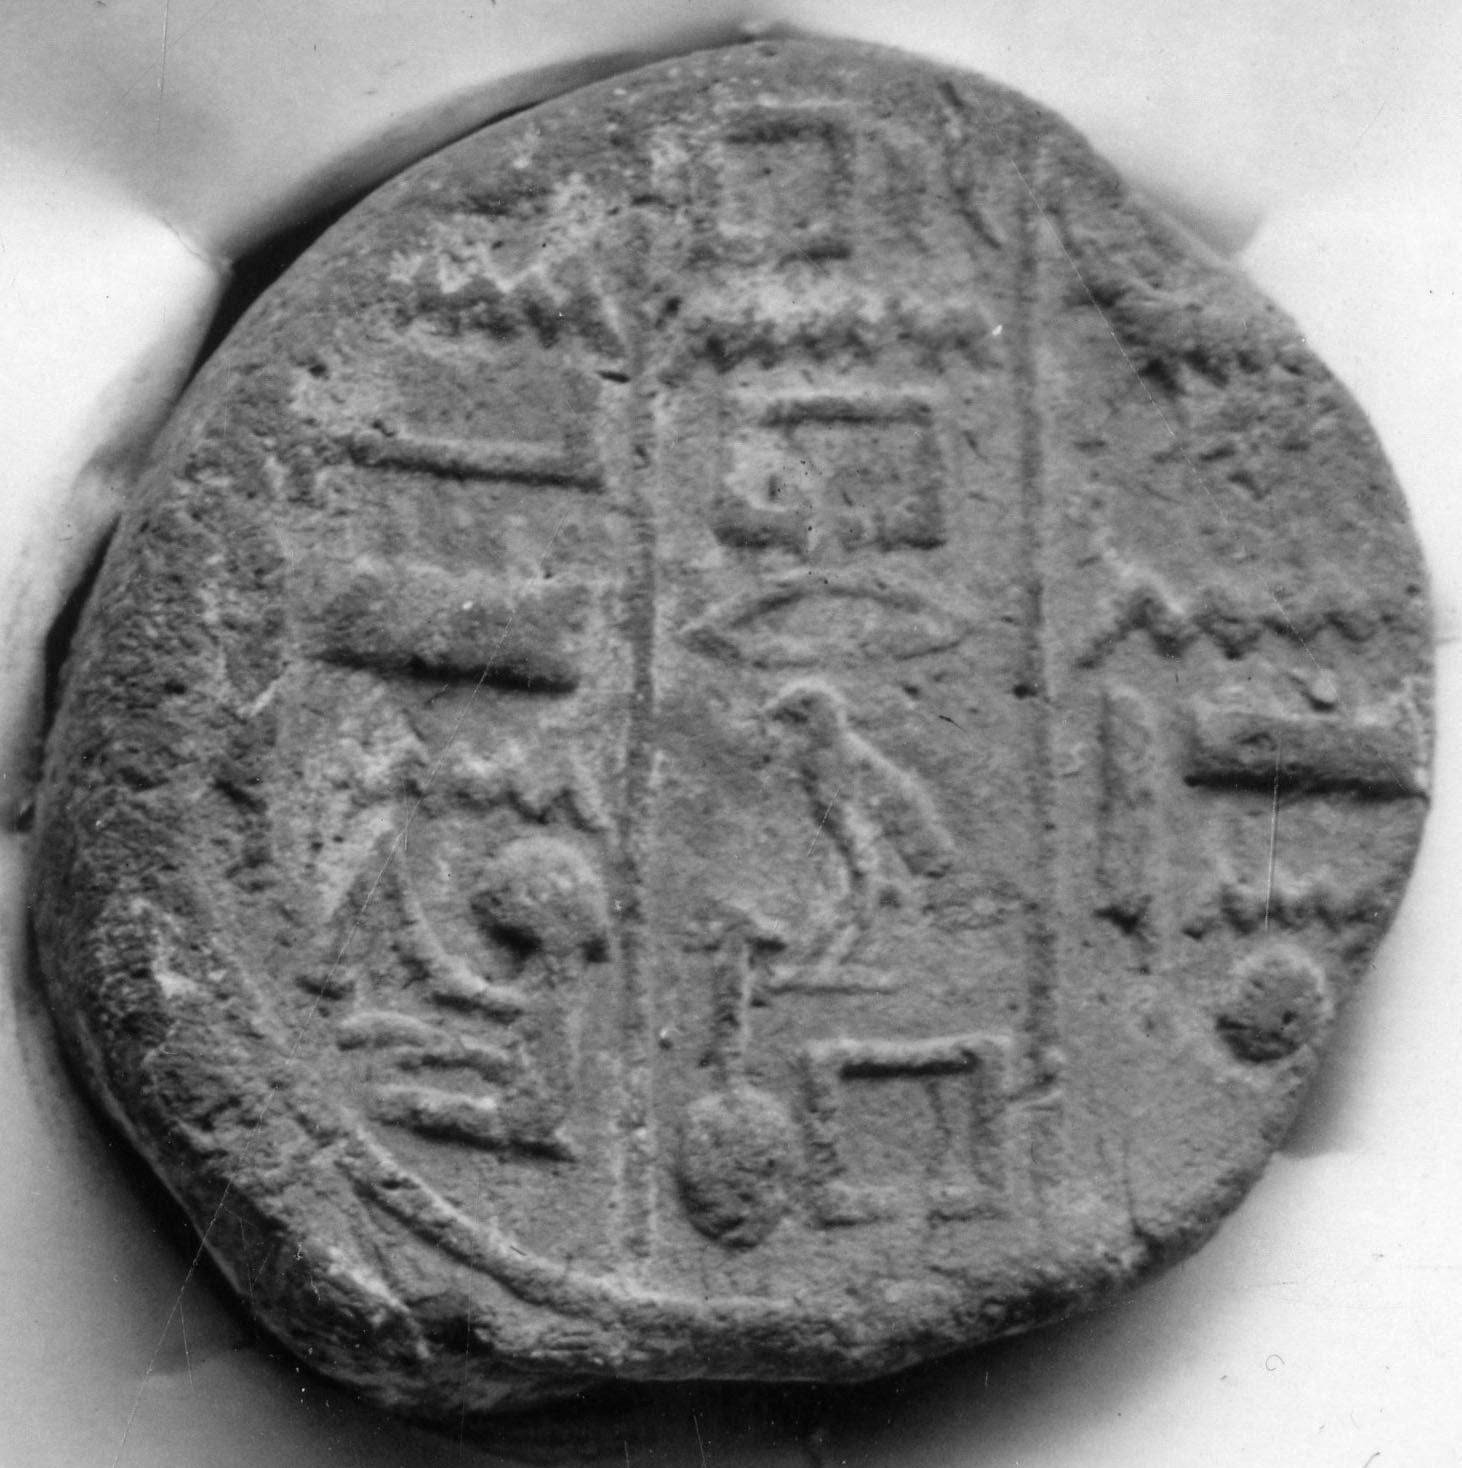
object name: cone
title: Funerary Cones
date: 1550-1295 BCE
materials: pottery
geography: egypt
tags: hieroglyphs